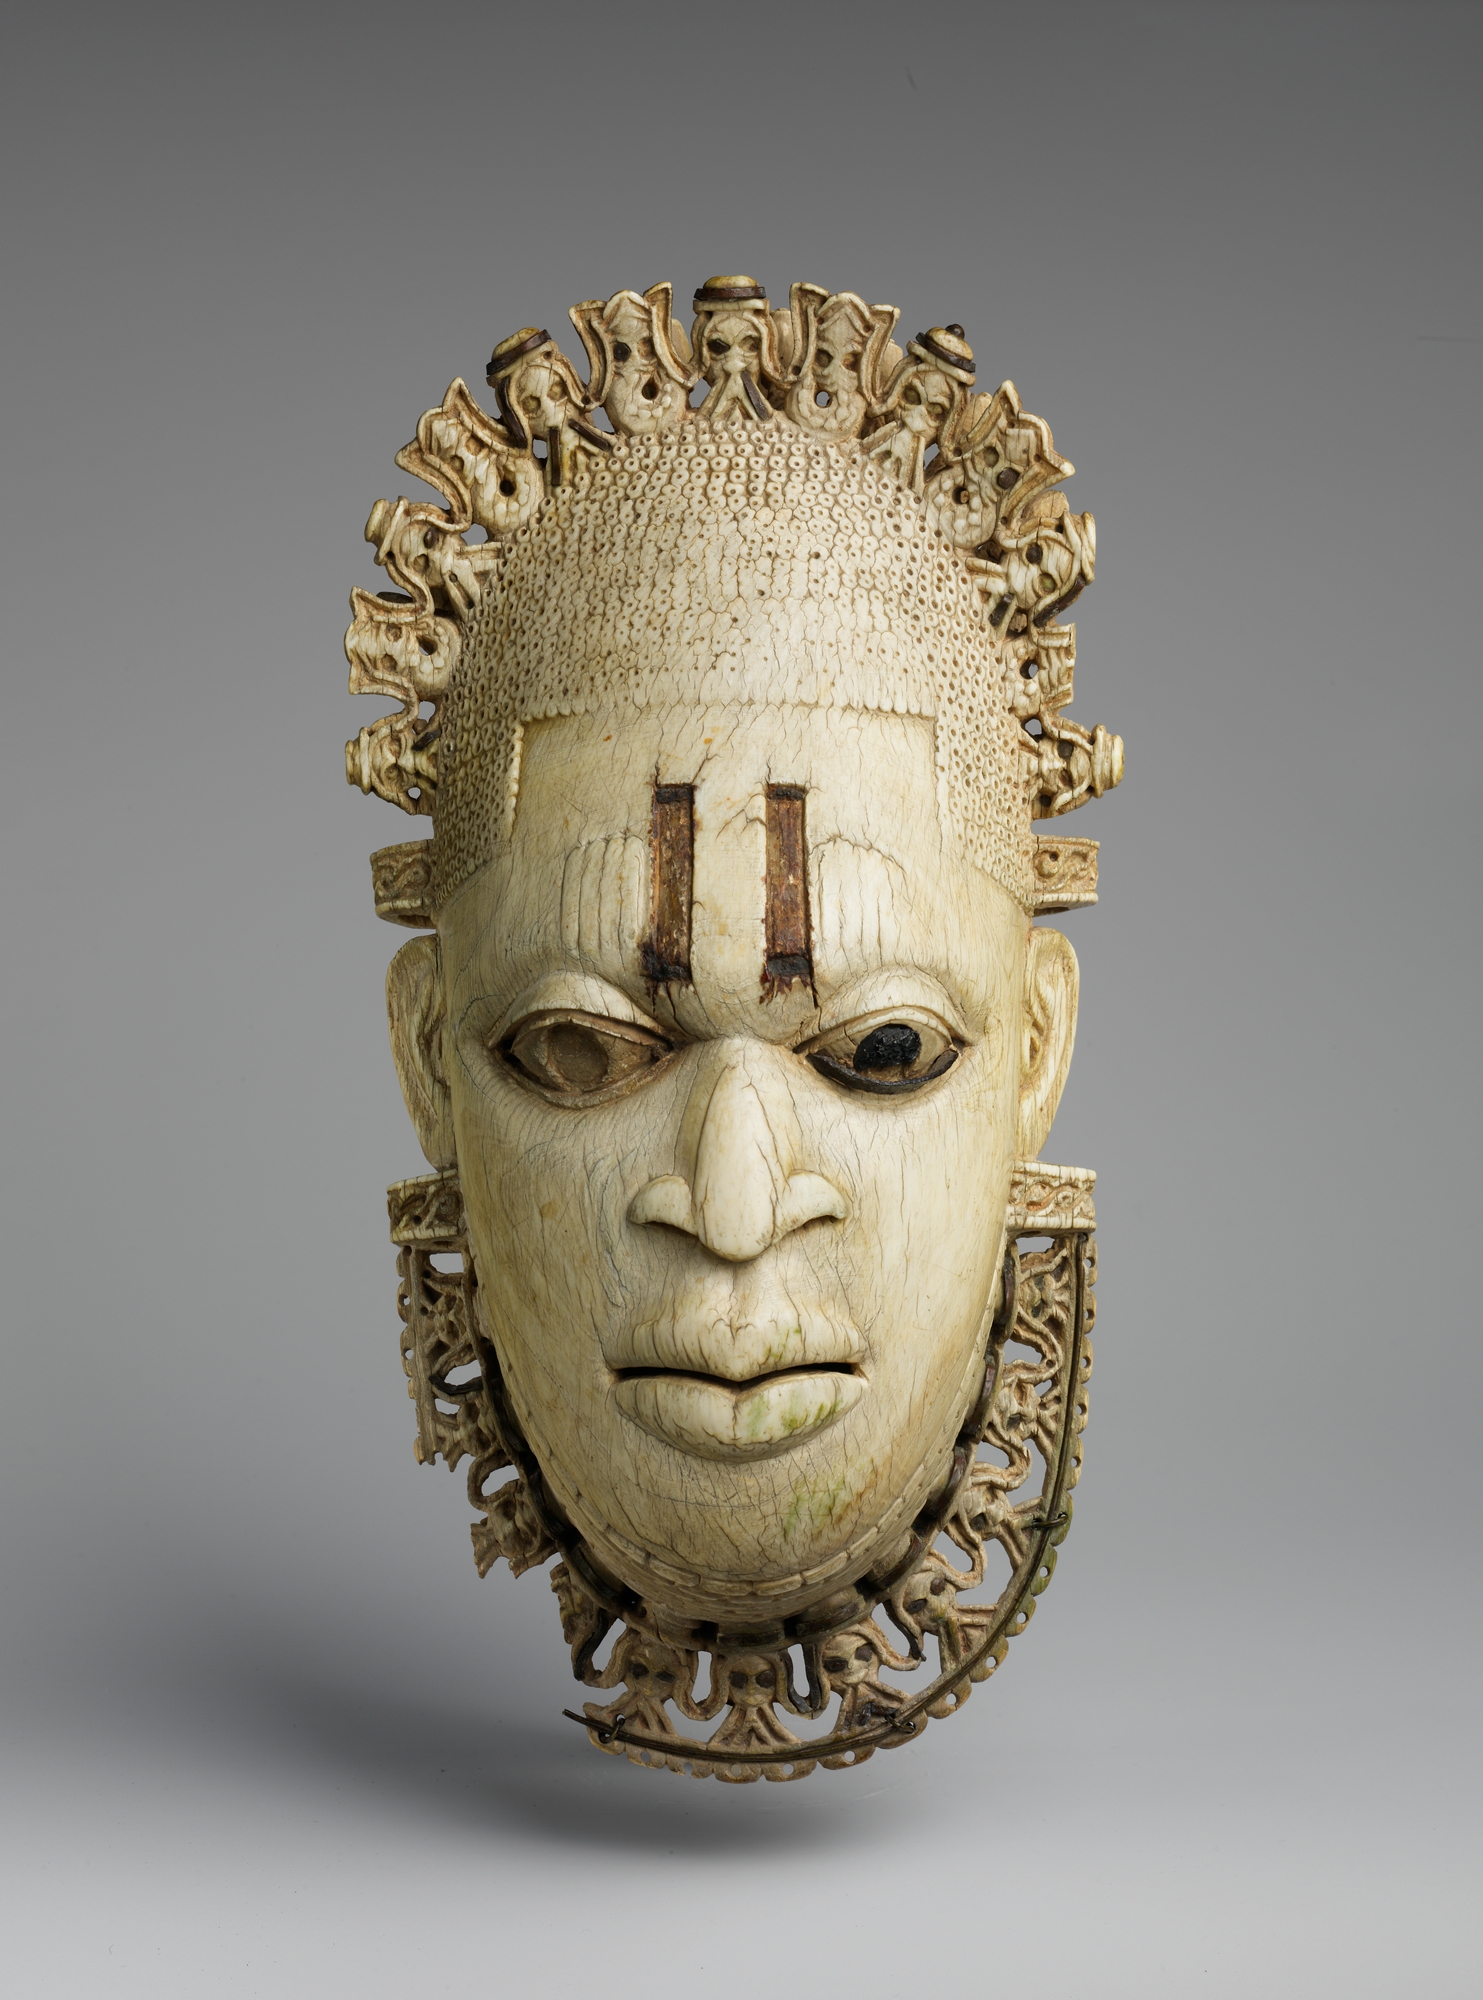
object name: pendant with female mask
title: Pendant mask of Ìyọ́bà Idià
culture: edo period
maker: ìgbèsànmwà (ivory- and wood- carving guild) artists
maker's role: artist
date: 1501-1600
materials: brass, iron, ivory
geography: nigeria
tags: portraits,women